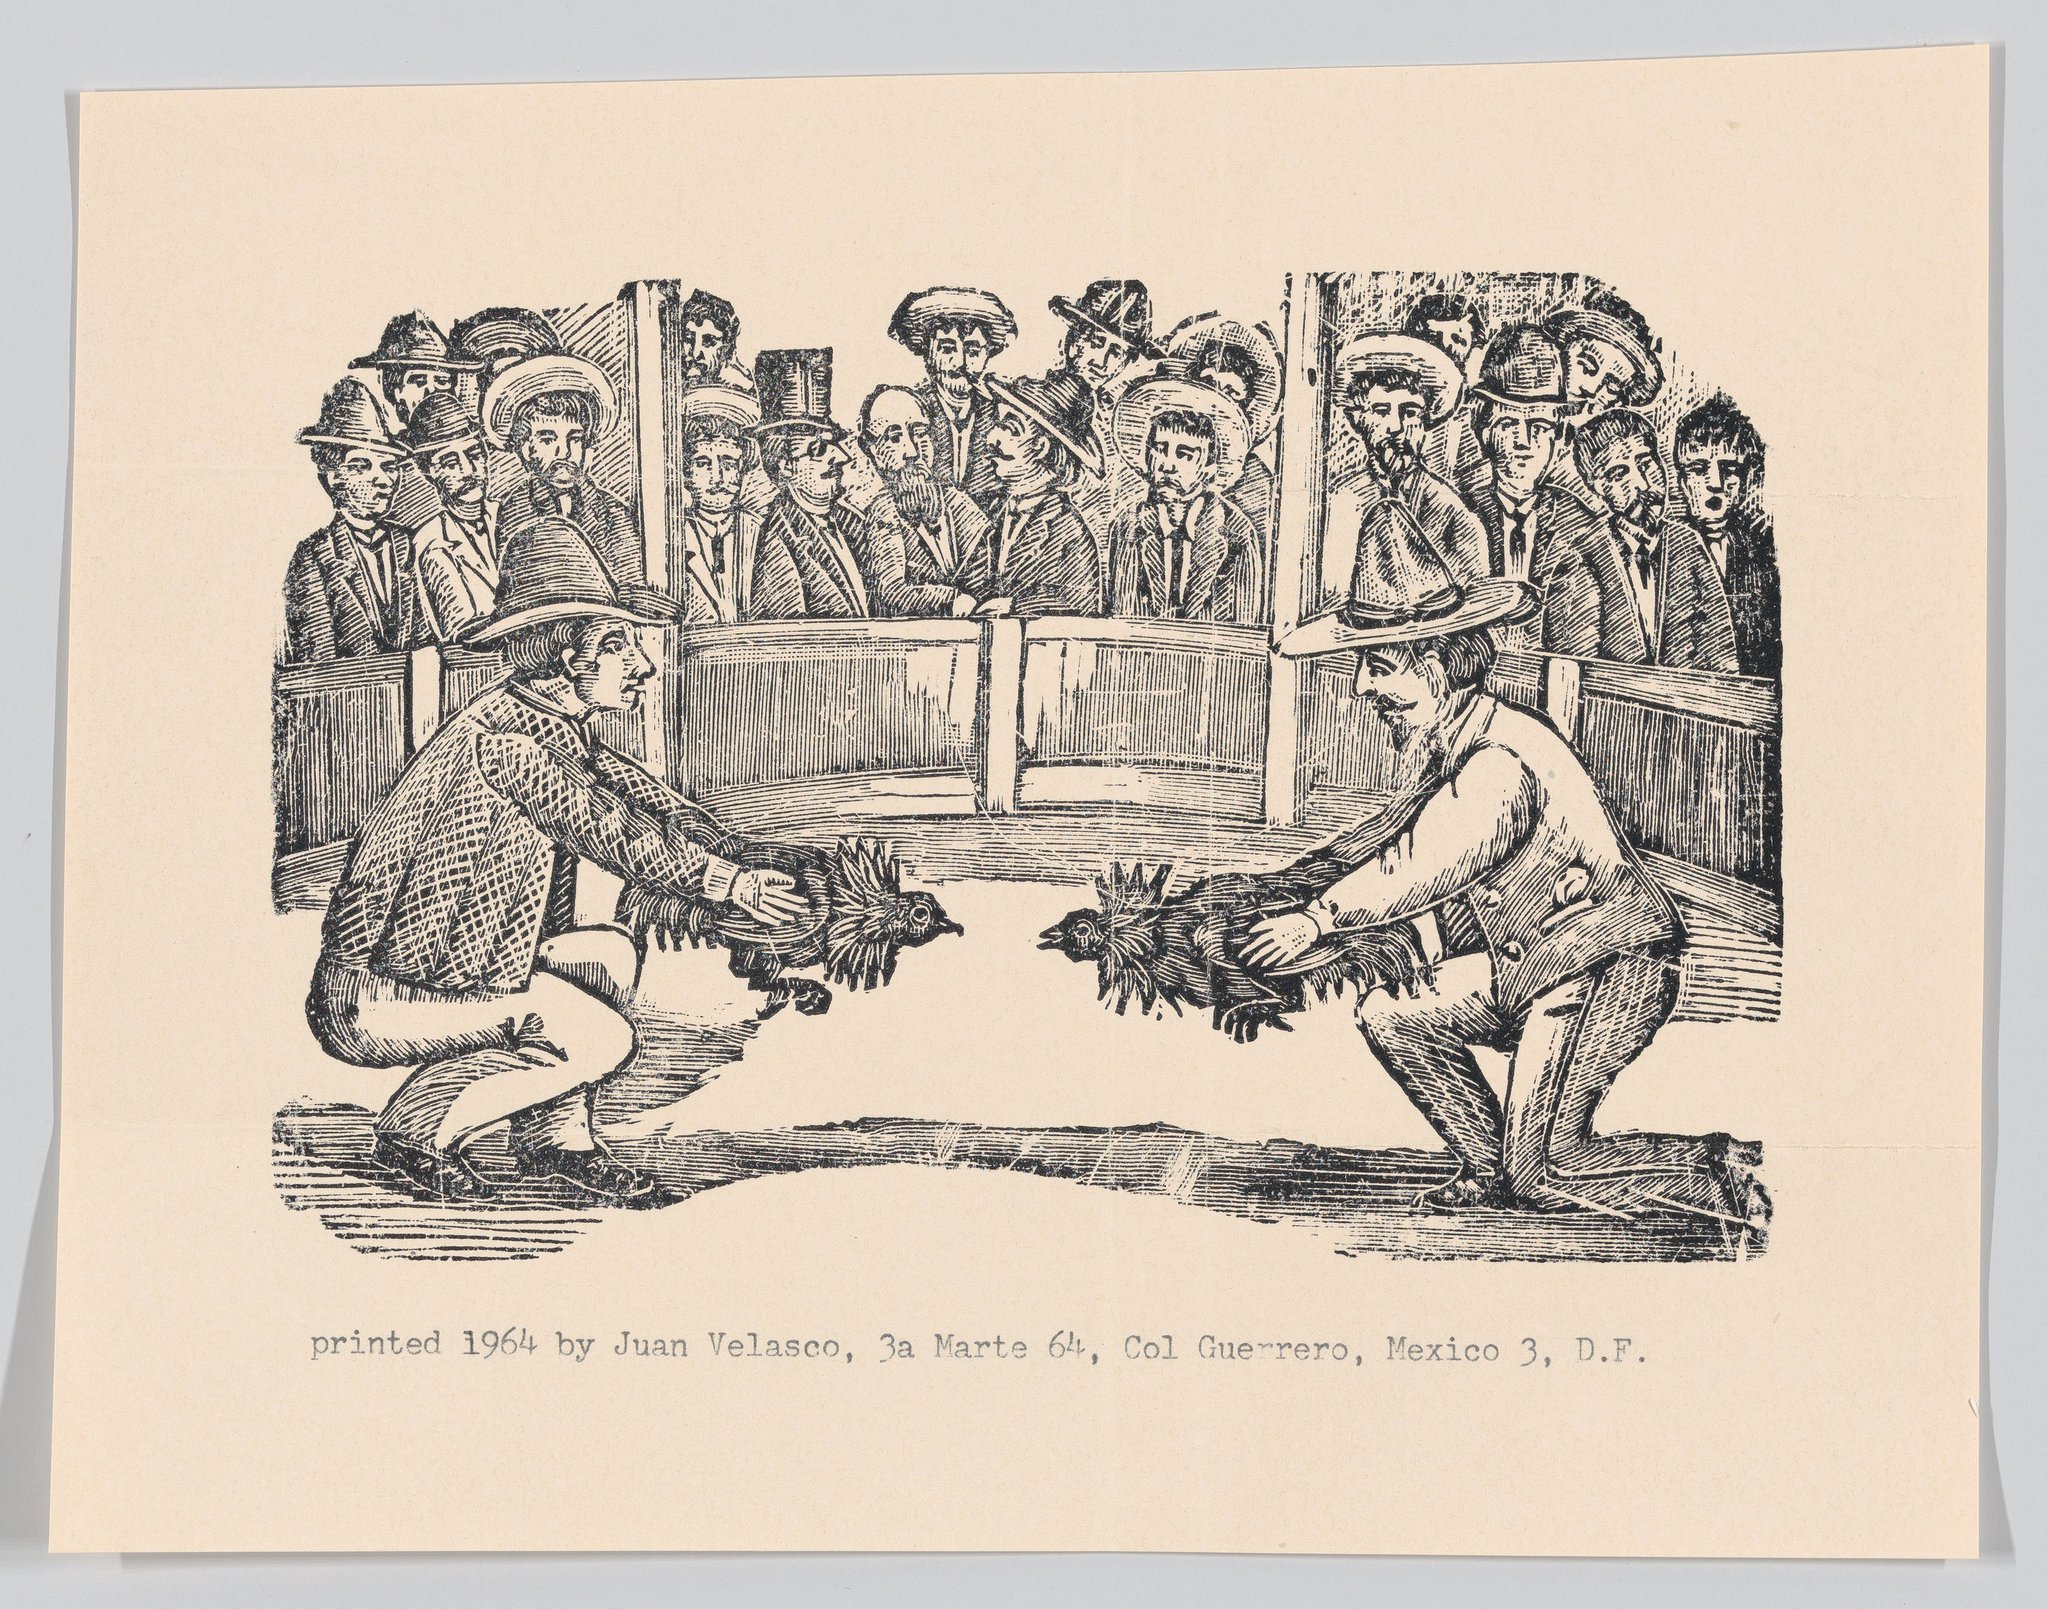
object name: print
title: Two men in an arena holding cocks in preparation for a fight, spectators around the perimeter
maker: josé guadalupe posada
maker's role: artist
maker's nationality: mexican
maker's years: 1852-1913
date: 1890-1910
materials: metal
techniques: engraving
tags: roosters,crowd